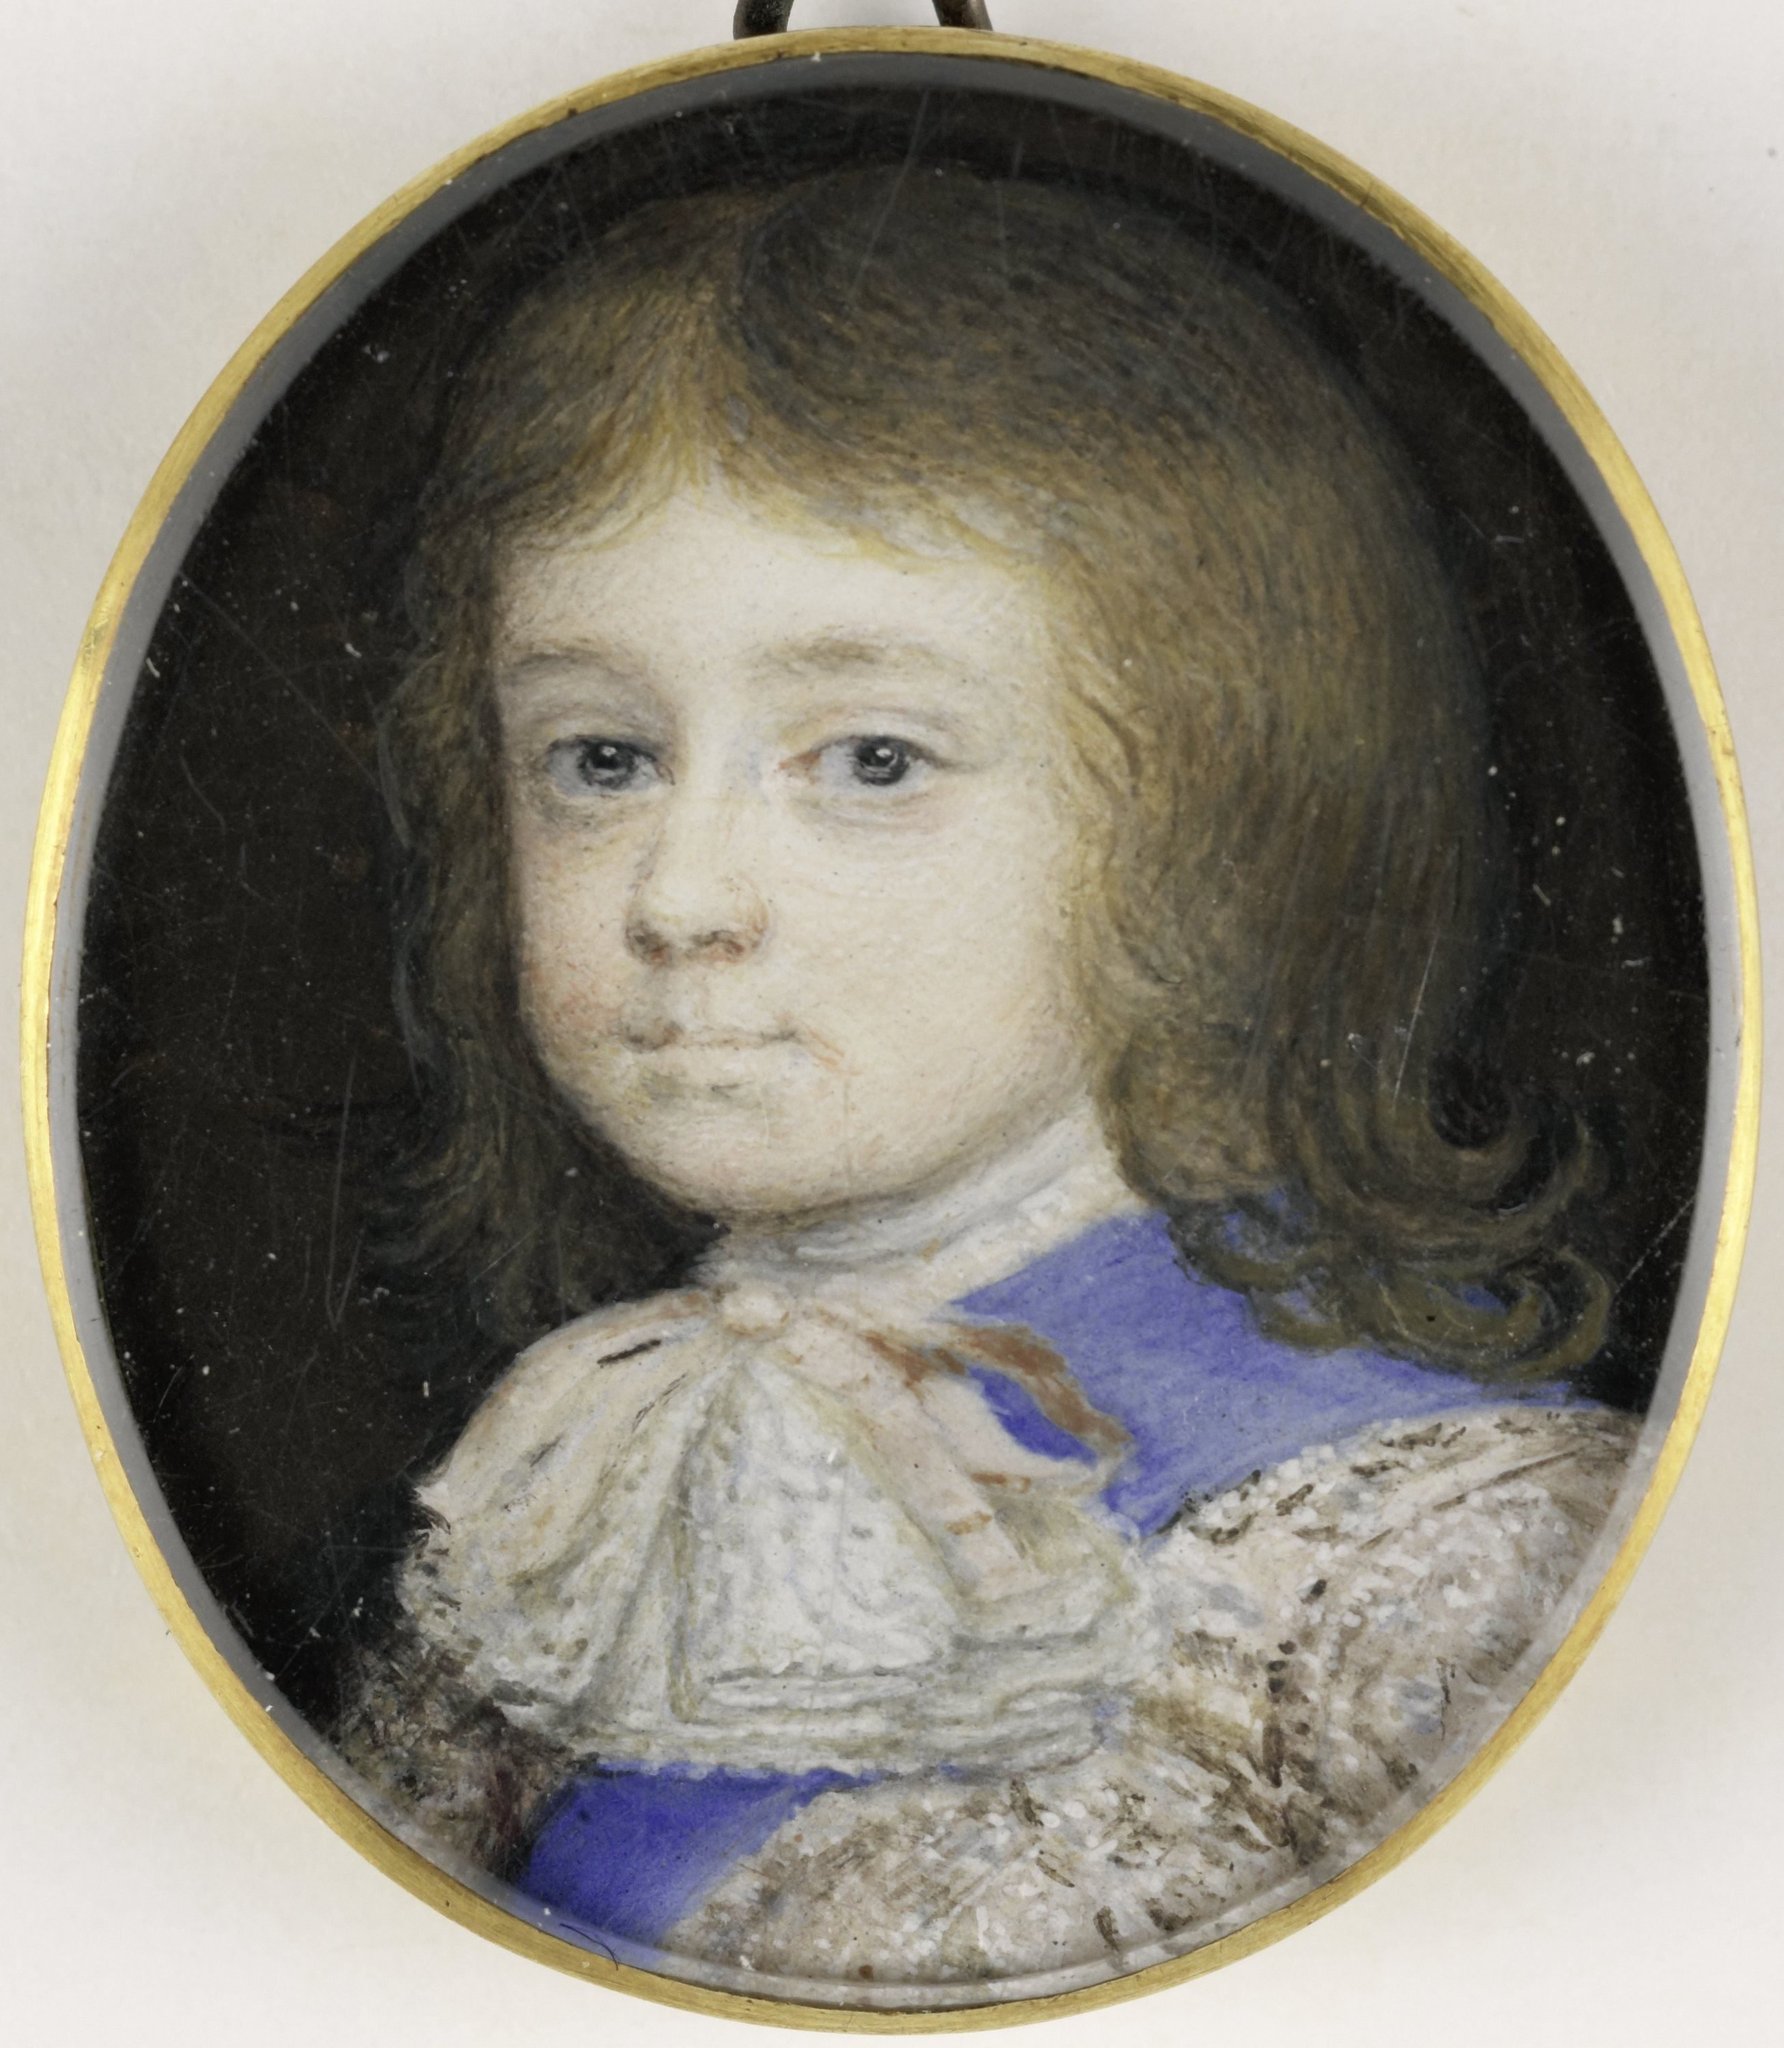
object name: painting, miniature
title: Jacobus (1663-67), hertog van Cambridge. Zoon van Jacobus II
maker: Anonymous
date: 1665-1670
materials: glass, metal, parchment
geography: england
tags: jacobus stuart (hertog van cambridge)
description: Portret van Jacobus Stuart (1663-67), hertog van Cambridge. Zoon van Jacobus II. Buste, naar links. Naar een origineel door John Michael Wright. Onderdeel van de collectie portretminiaturen.